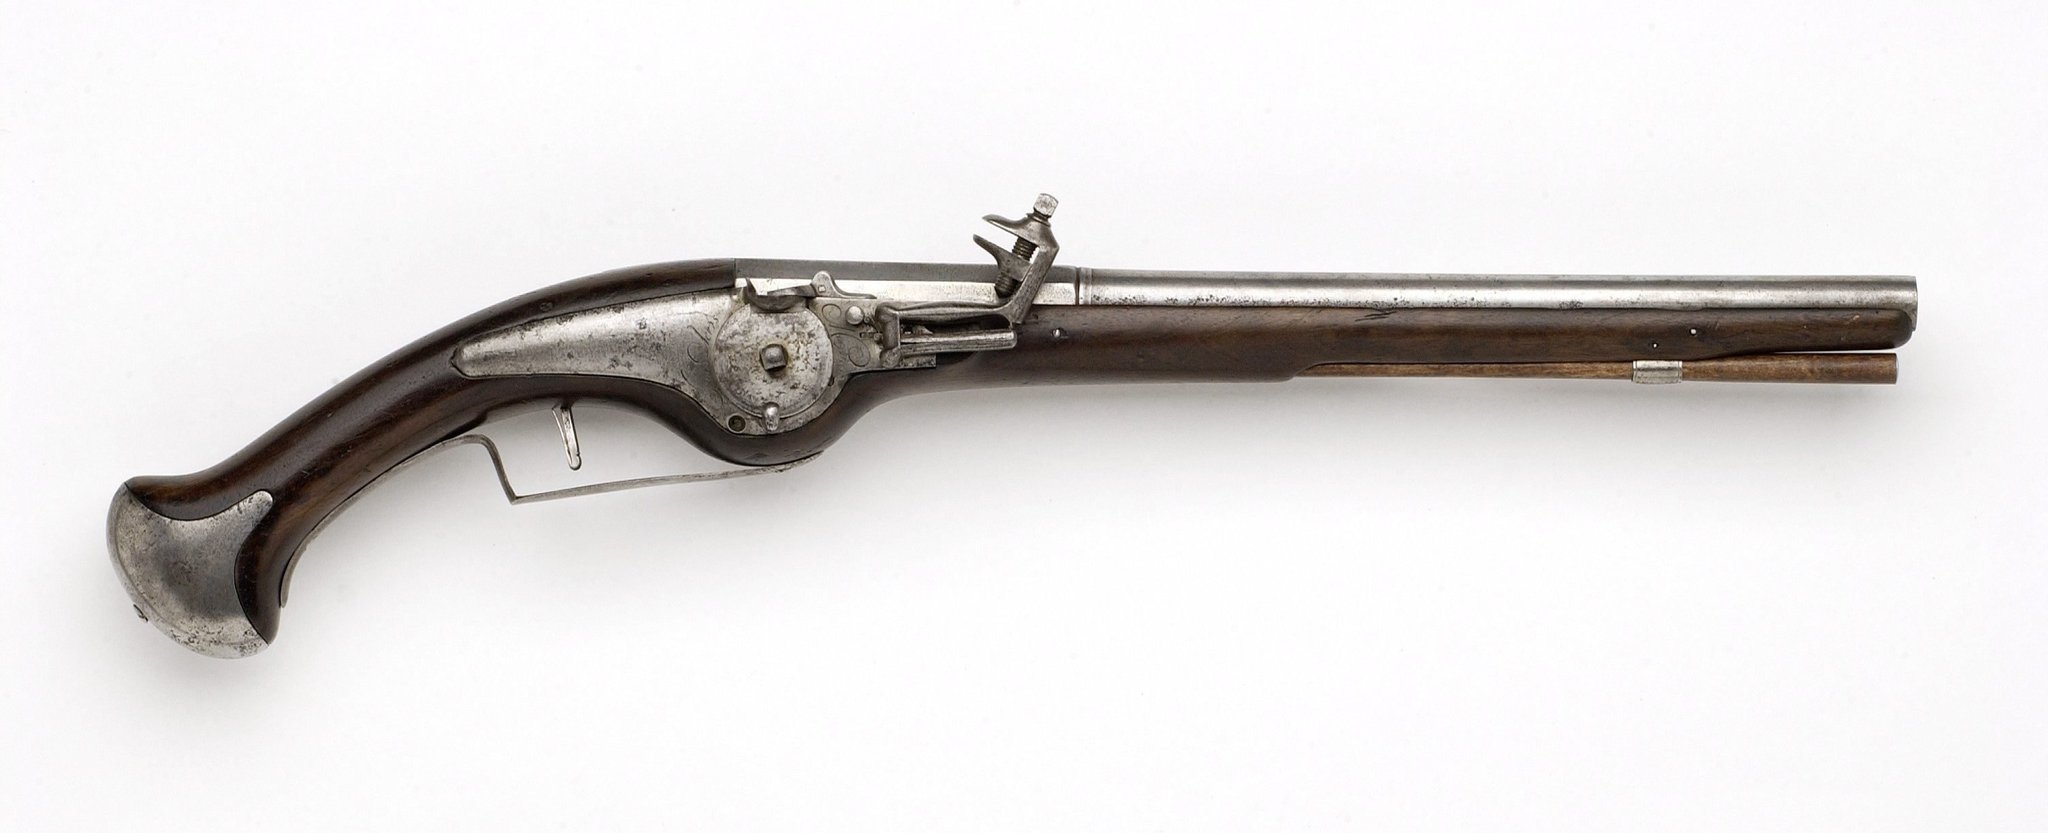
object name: radslotpistool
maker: jan aerts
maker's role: geweermaker, lademaker, pistoolmaker, smid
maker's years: 1619-1657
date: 1655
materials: iron, wood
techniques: printing, engraving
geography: maastricht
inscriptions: signature: ‘Jean Aerts; Maestrech’, inscription: ‘Ezechias Colas Sedan; IB; S’